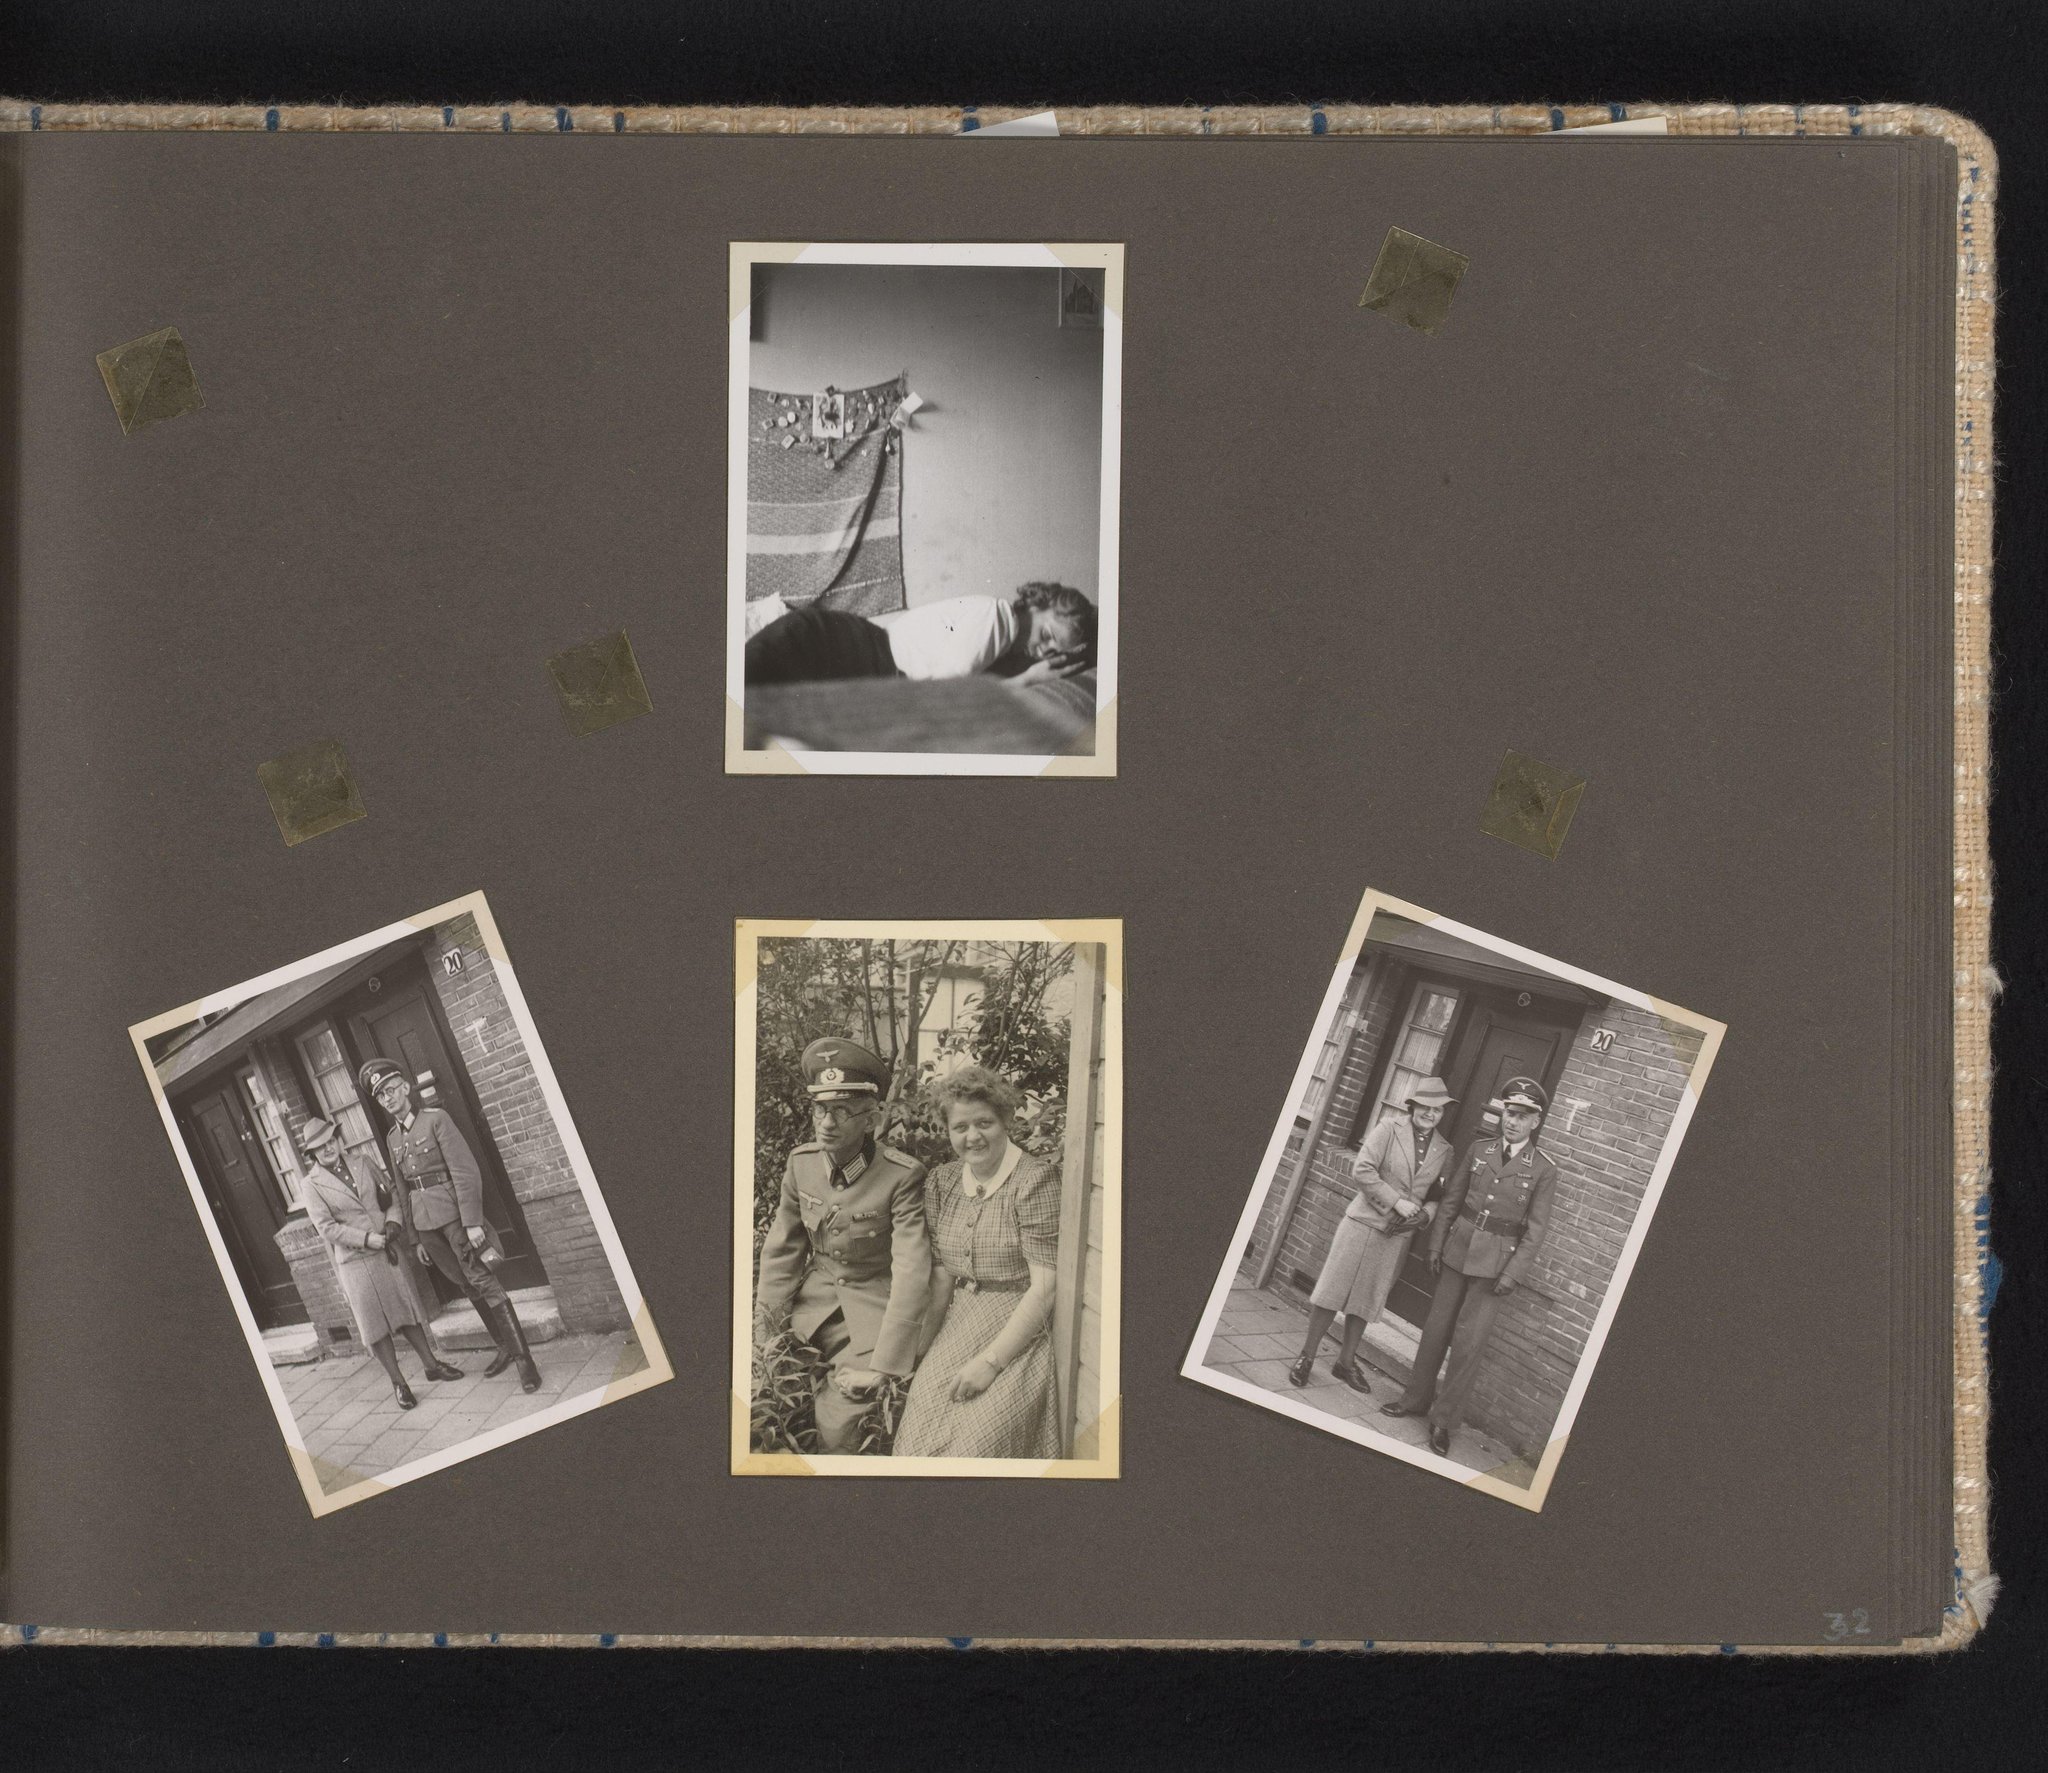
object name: photograph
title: Officier van de Wehrmacht met vrouw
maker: Anonymous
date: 1941-1942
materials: cardboard, photographic support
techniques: gelatin silver print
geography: netherlands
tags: leave ~ the soldier off duty, occupier and civilians, occupation ~ war, netherlands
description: Albumblad met vier foto's van een officier van de Wehrmacht (vermoedelijk de samensteller van het album) en zijn vrouw. Onderdeel van het fotoalbum Abrechnungsintendantur van de Wehrmacht 1941-1943.